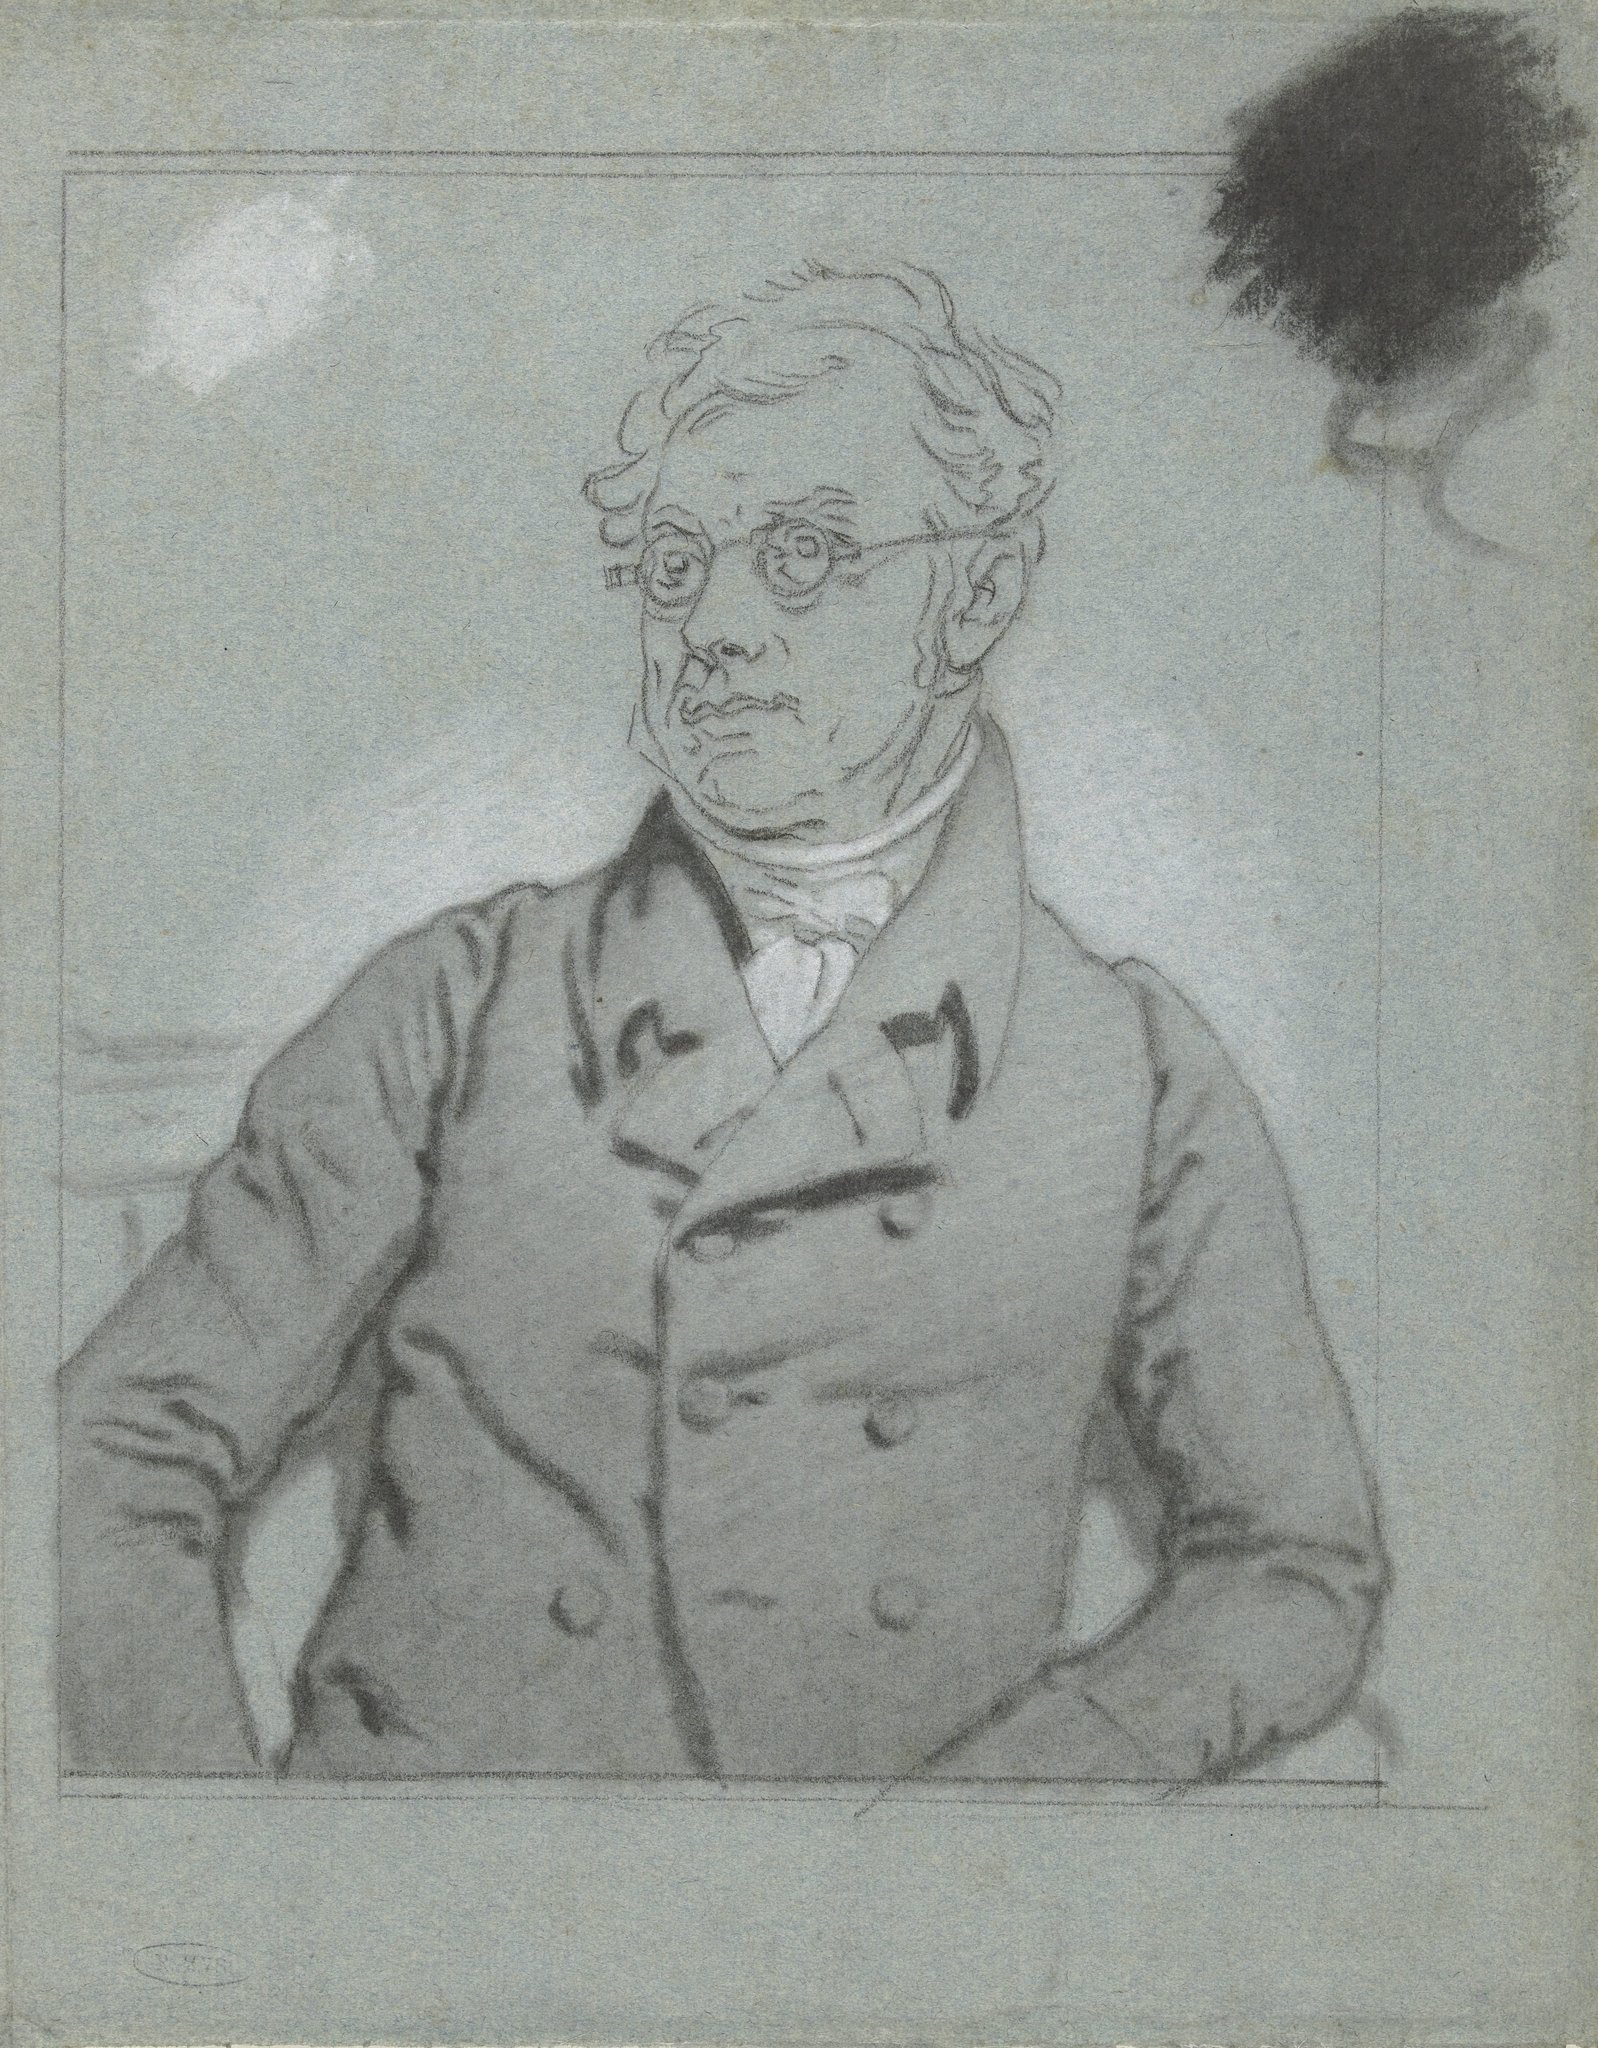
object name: drawing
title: Mansportret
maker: charles howard hodges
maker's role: draughtsman, painter, print maker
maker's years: 1764-1837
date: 1774-1837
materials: chalk, paper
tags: anonymous historical person portrayed alone